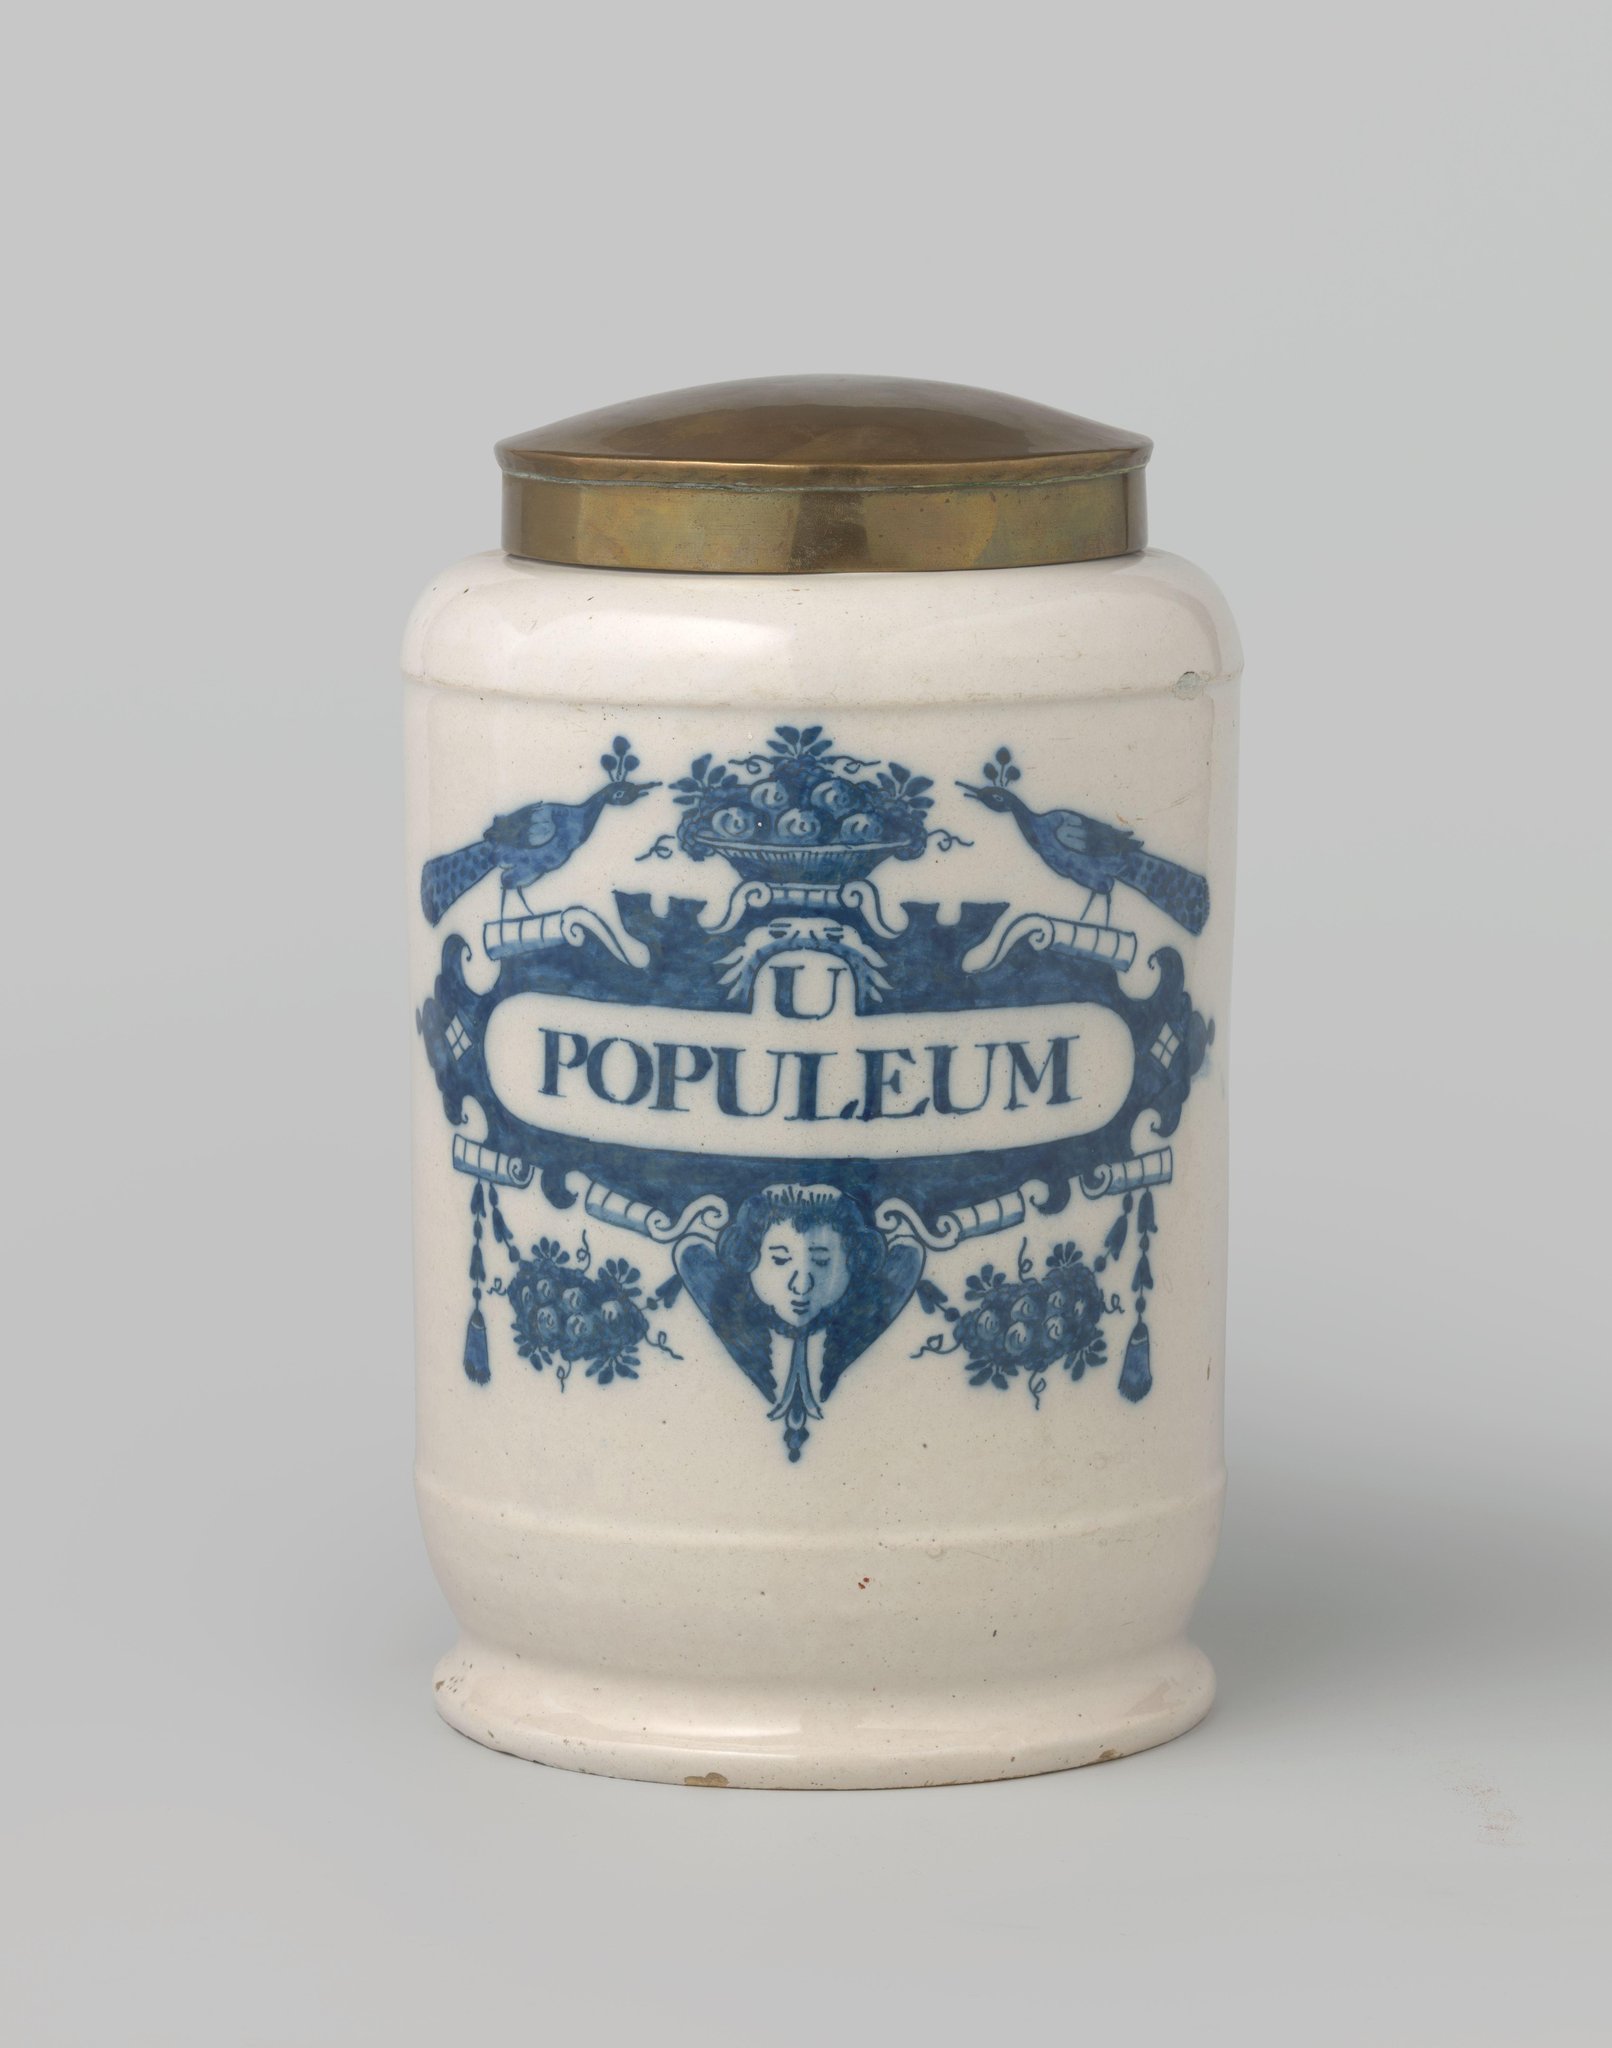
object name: apothecary jar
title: Delftse apothekerspot POPULEUM met deksel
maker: Anonymous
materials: copper, earthenware, glaze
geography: delft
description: Delftse cylindervormige apothekerspot met in blauw onderglazuur beschilderd cartouche met naam medicament 'POPULEUM' waarboven de letter 'U', gehouden door twee pauwen en bekroond door fruitmand. Langs onderkant twee vruchtenslingers. Met deksel van koper.